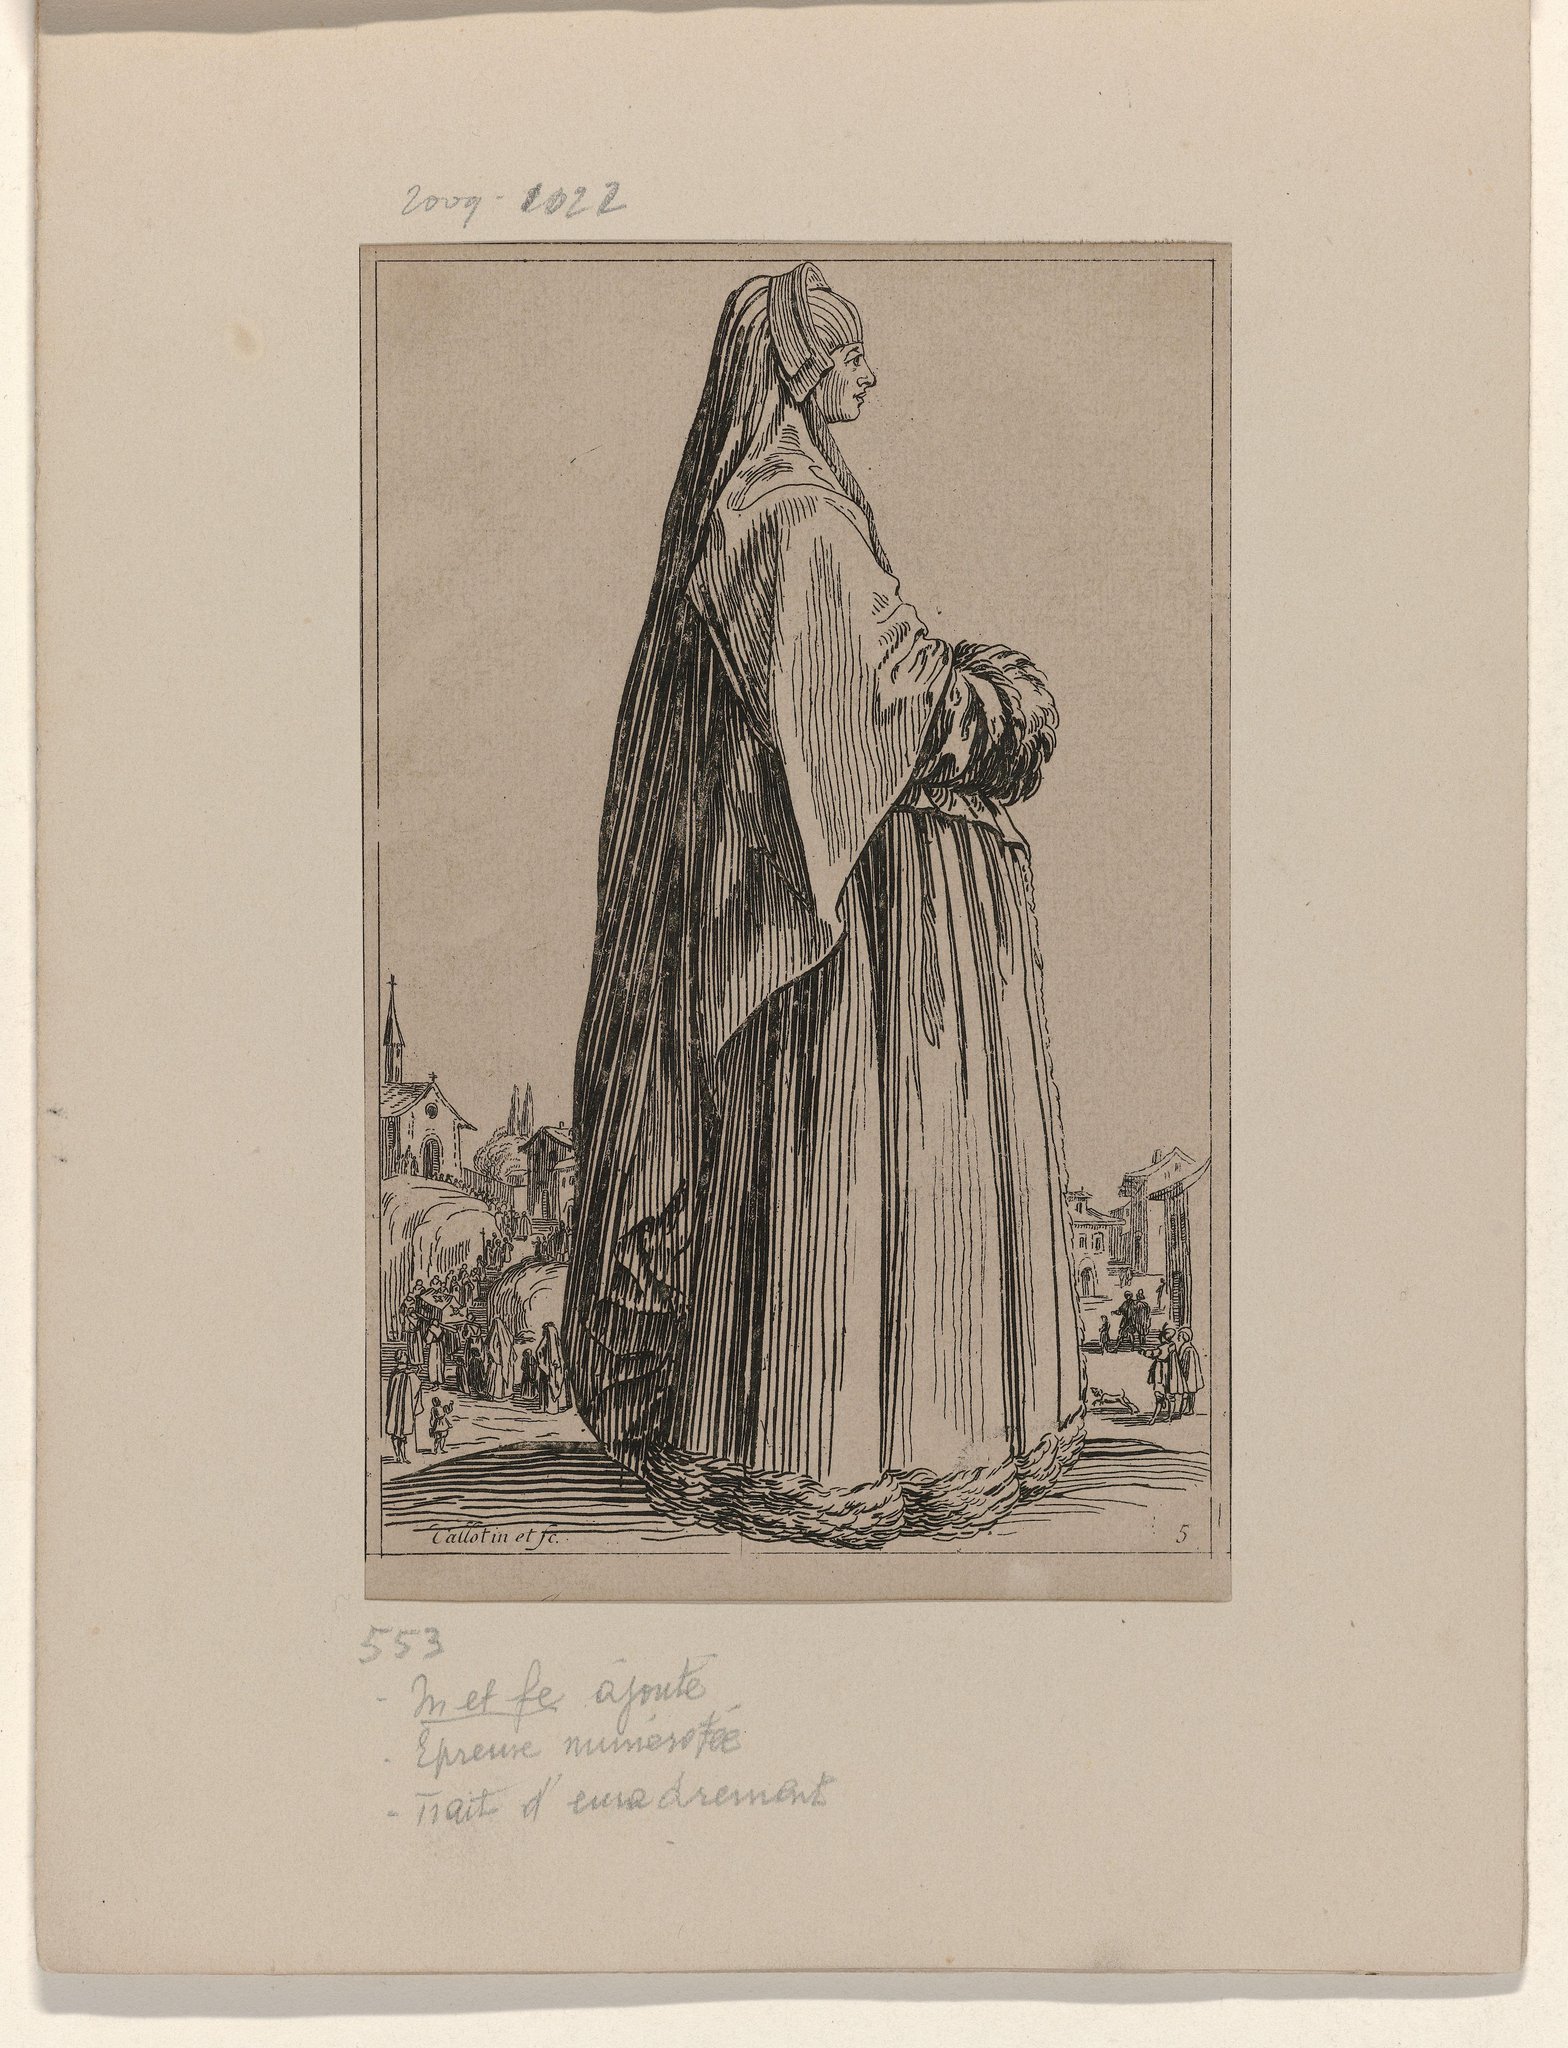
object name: print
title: La Noblesse de Lorraine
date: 1700-1799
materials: paper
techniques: etching